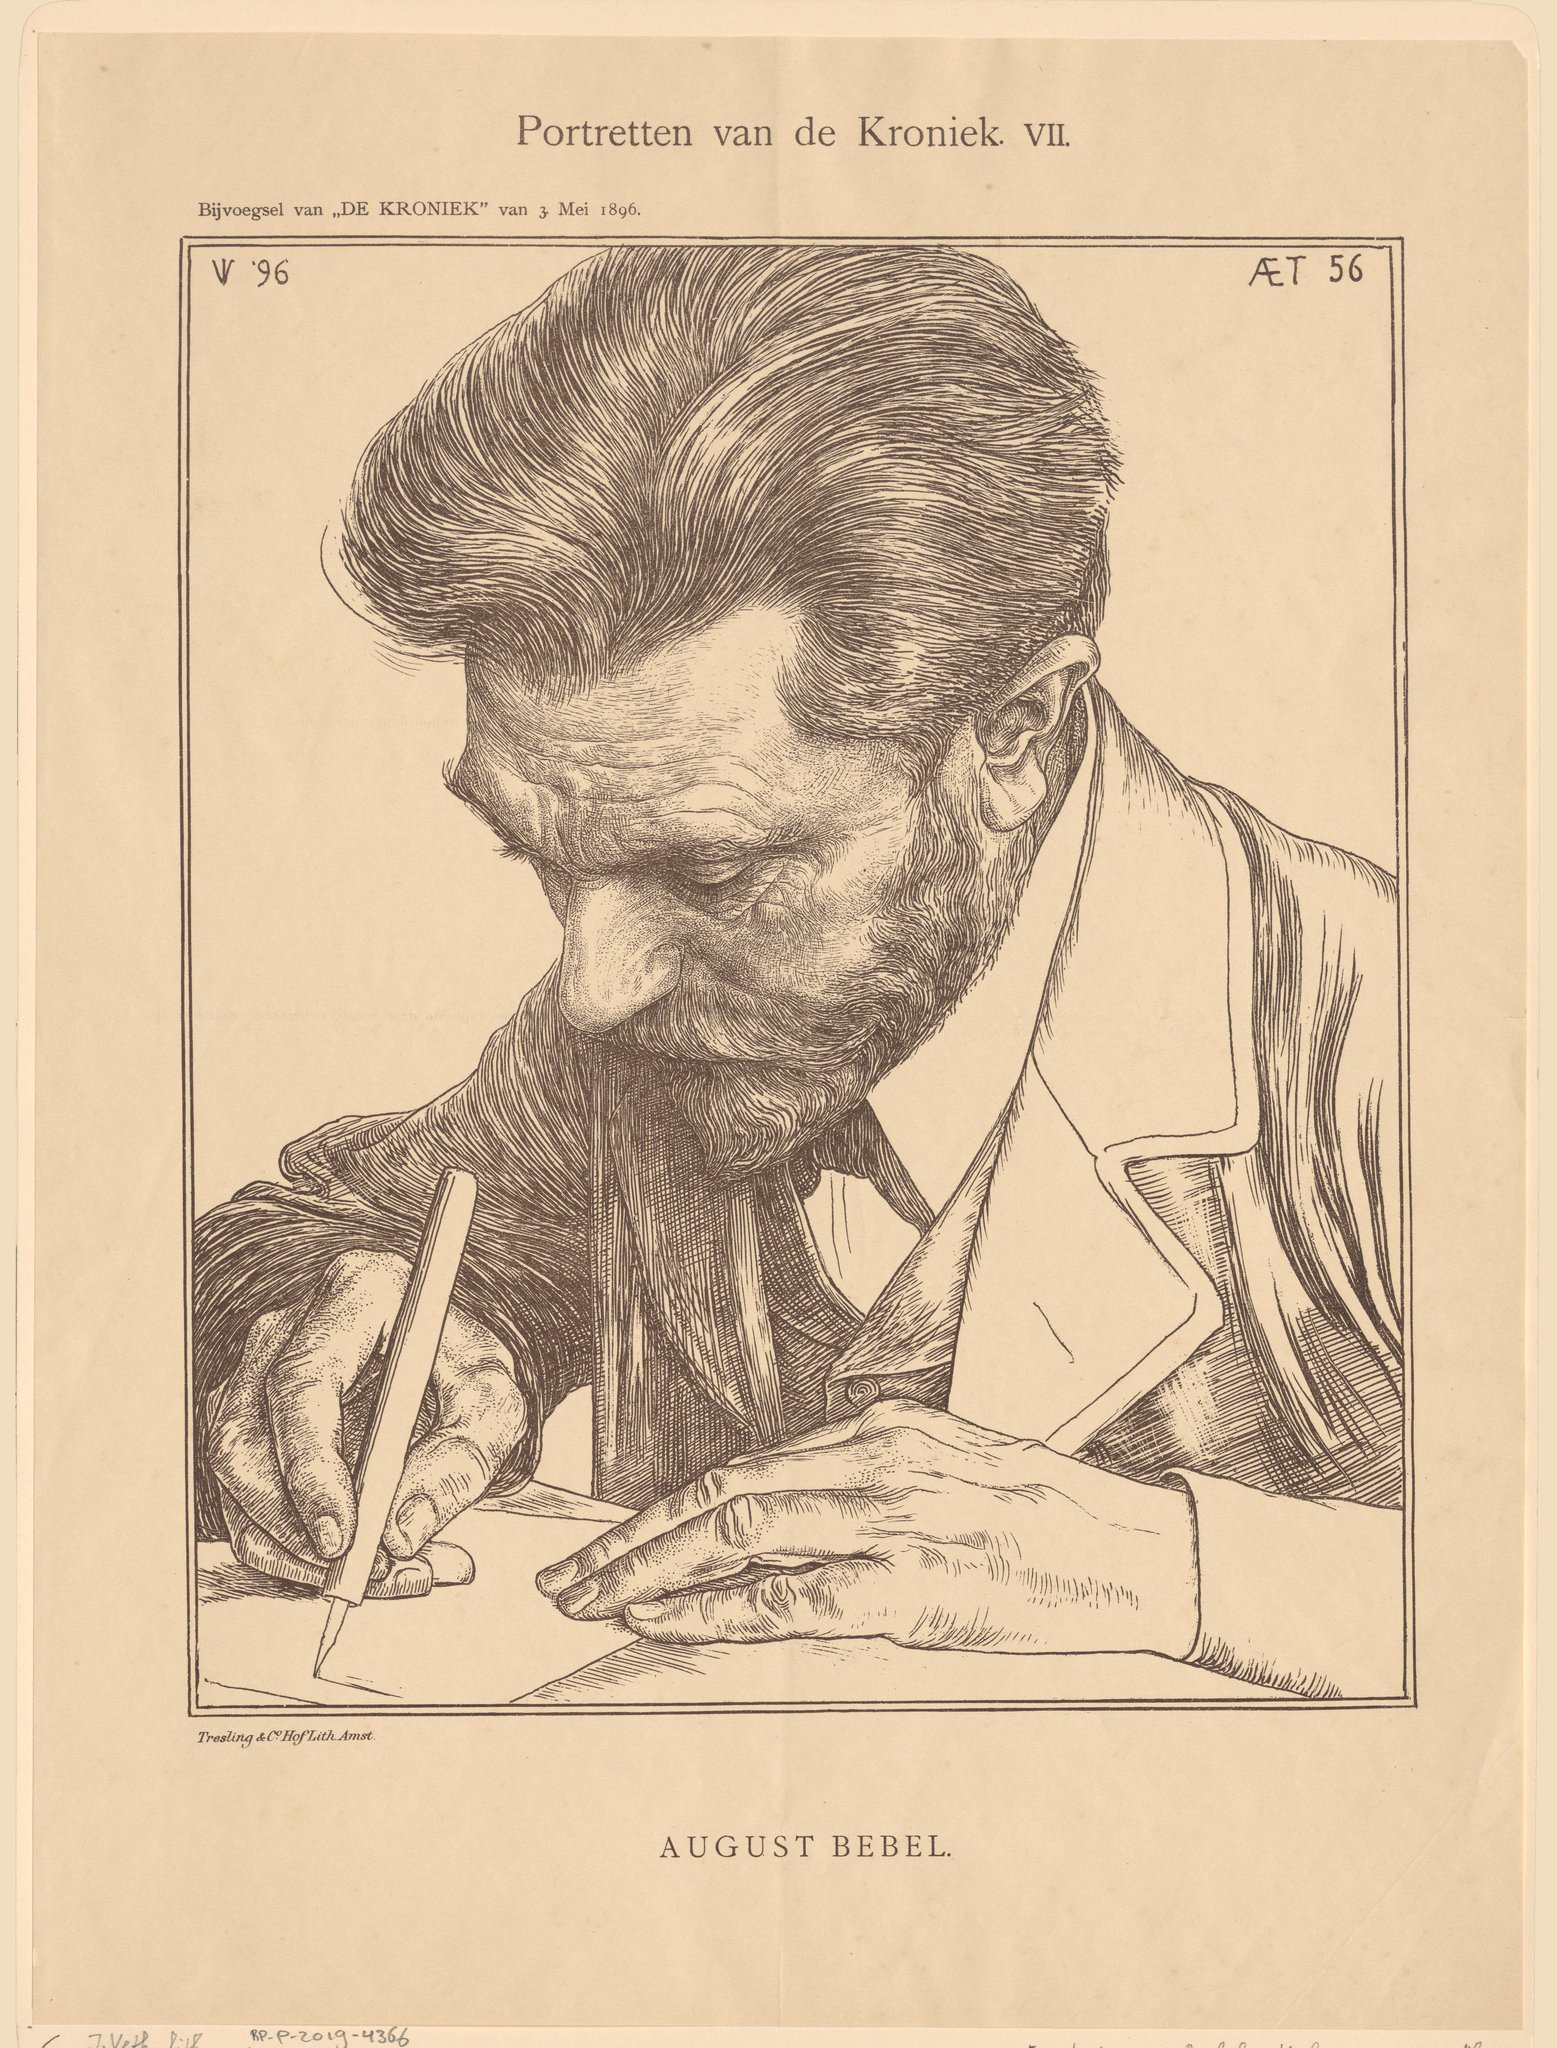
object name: book illustration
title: Portret van August Bebel op 56-jarige leeftijd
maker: jan veth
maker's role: designer, draughtsman, painter, print maker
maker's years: 1864-1925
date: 1896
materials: paper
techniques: lithograph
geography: amsterdam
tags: politician, historical persons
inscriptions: date